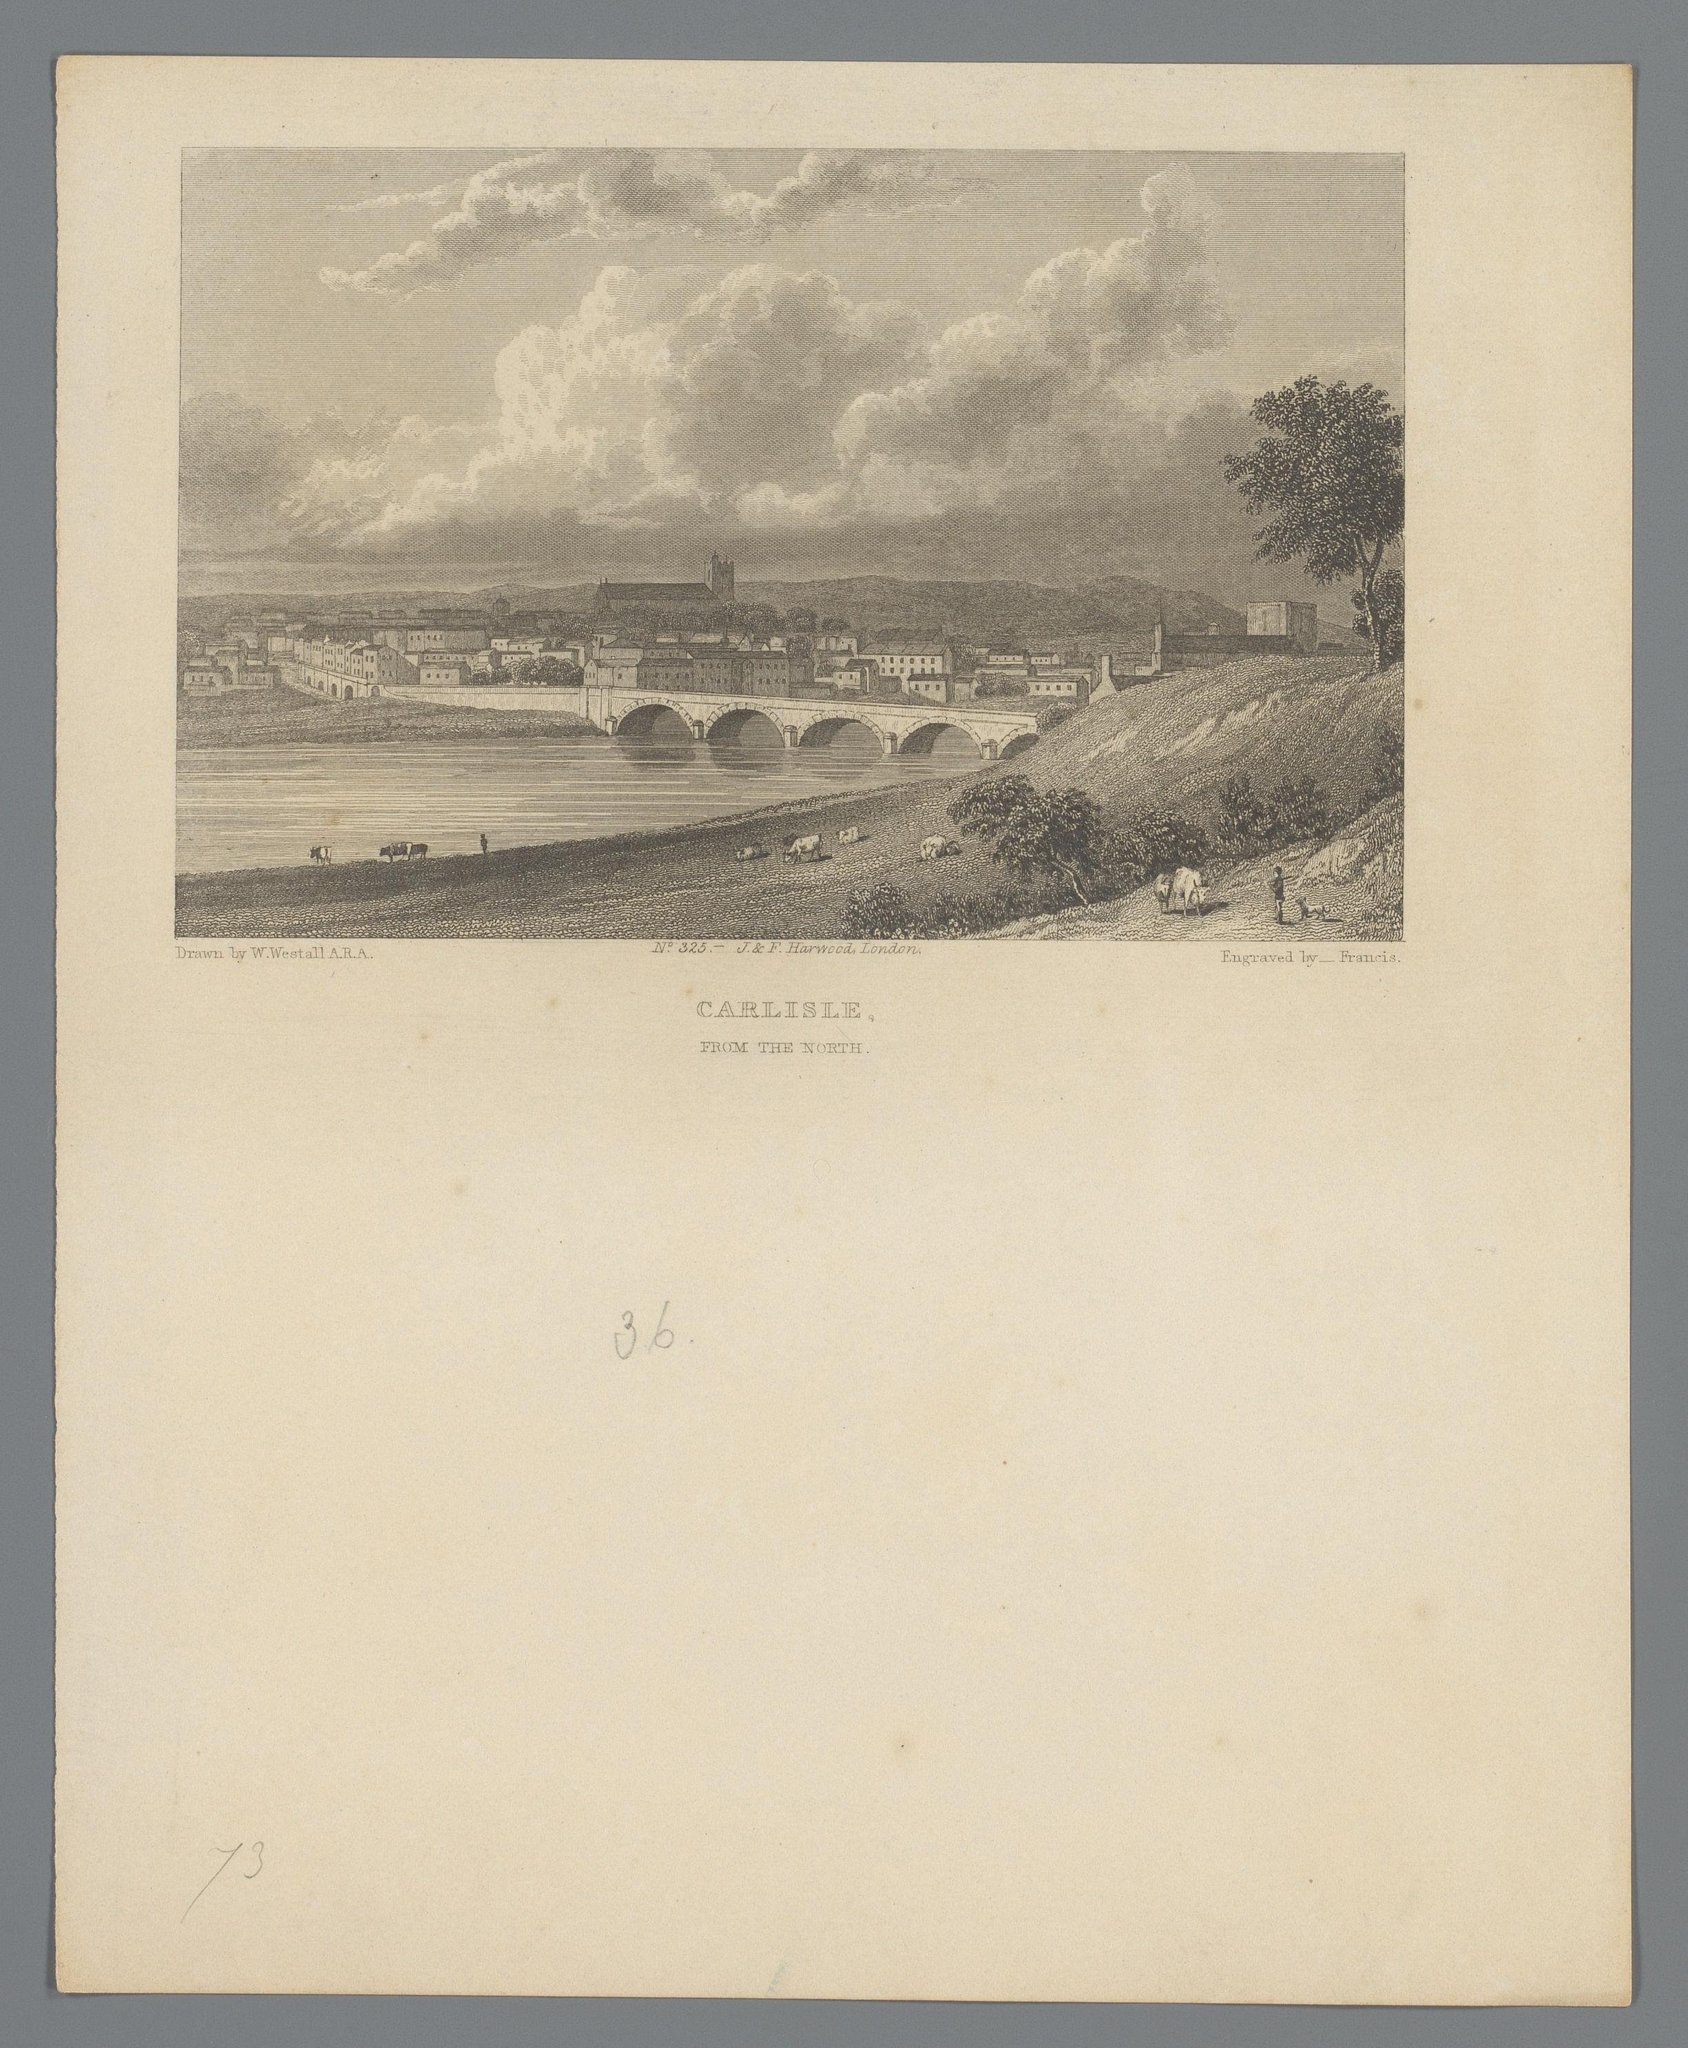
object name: stationery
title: Briefpapier met voorstelling van de stad Carlisle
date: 1840-1850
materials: paper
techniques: engraving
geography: london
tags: prospect of city, town panorama, silhouette of city